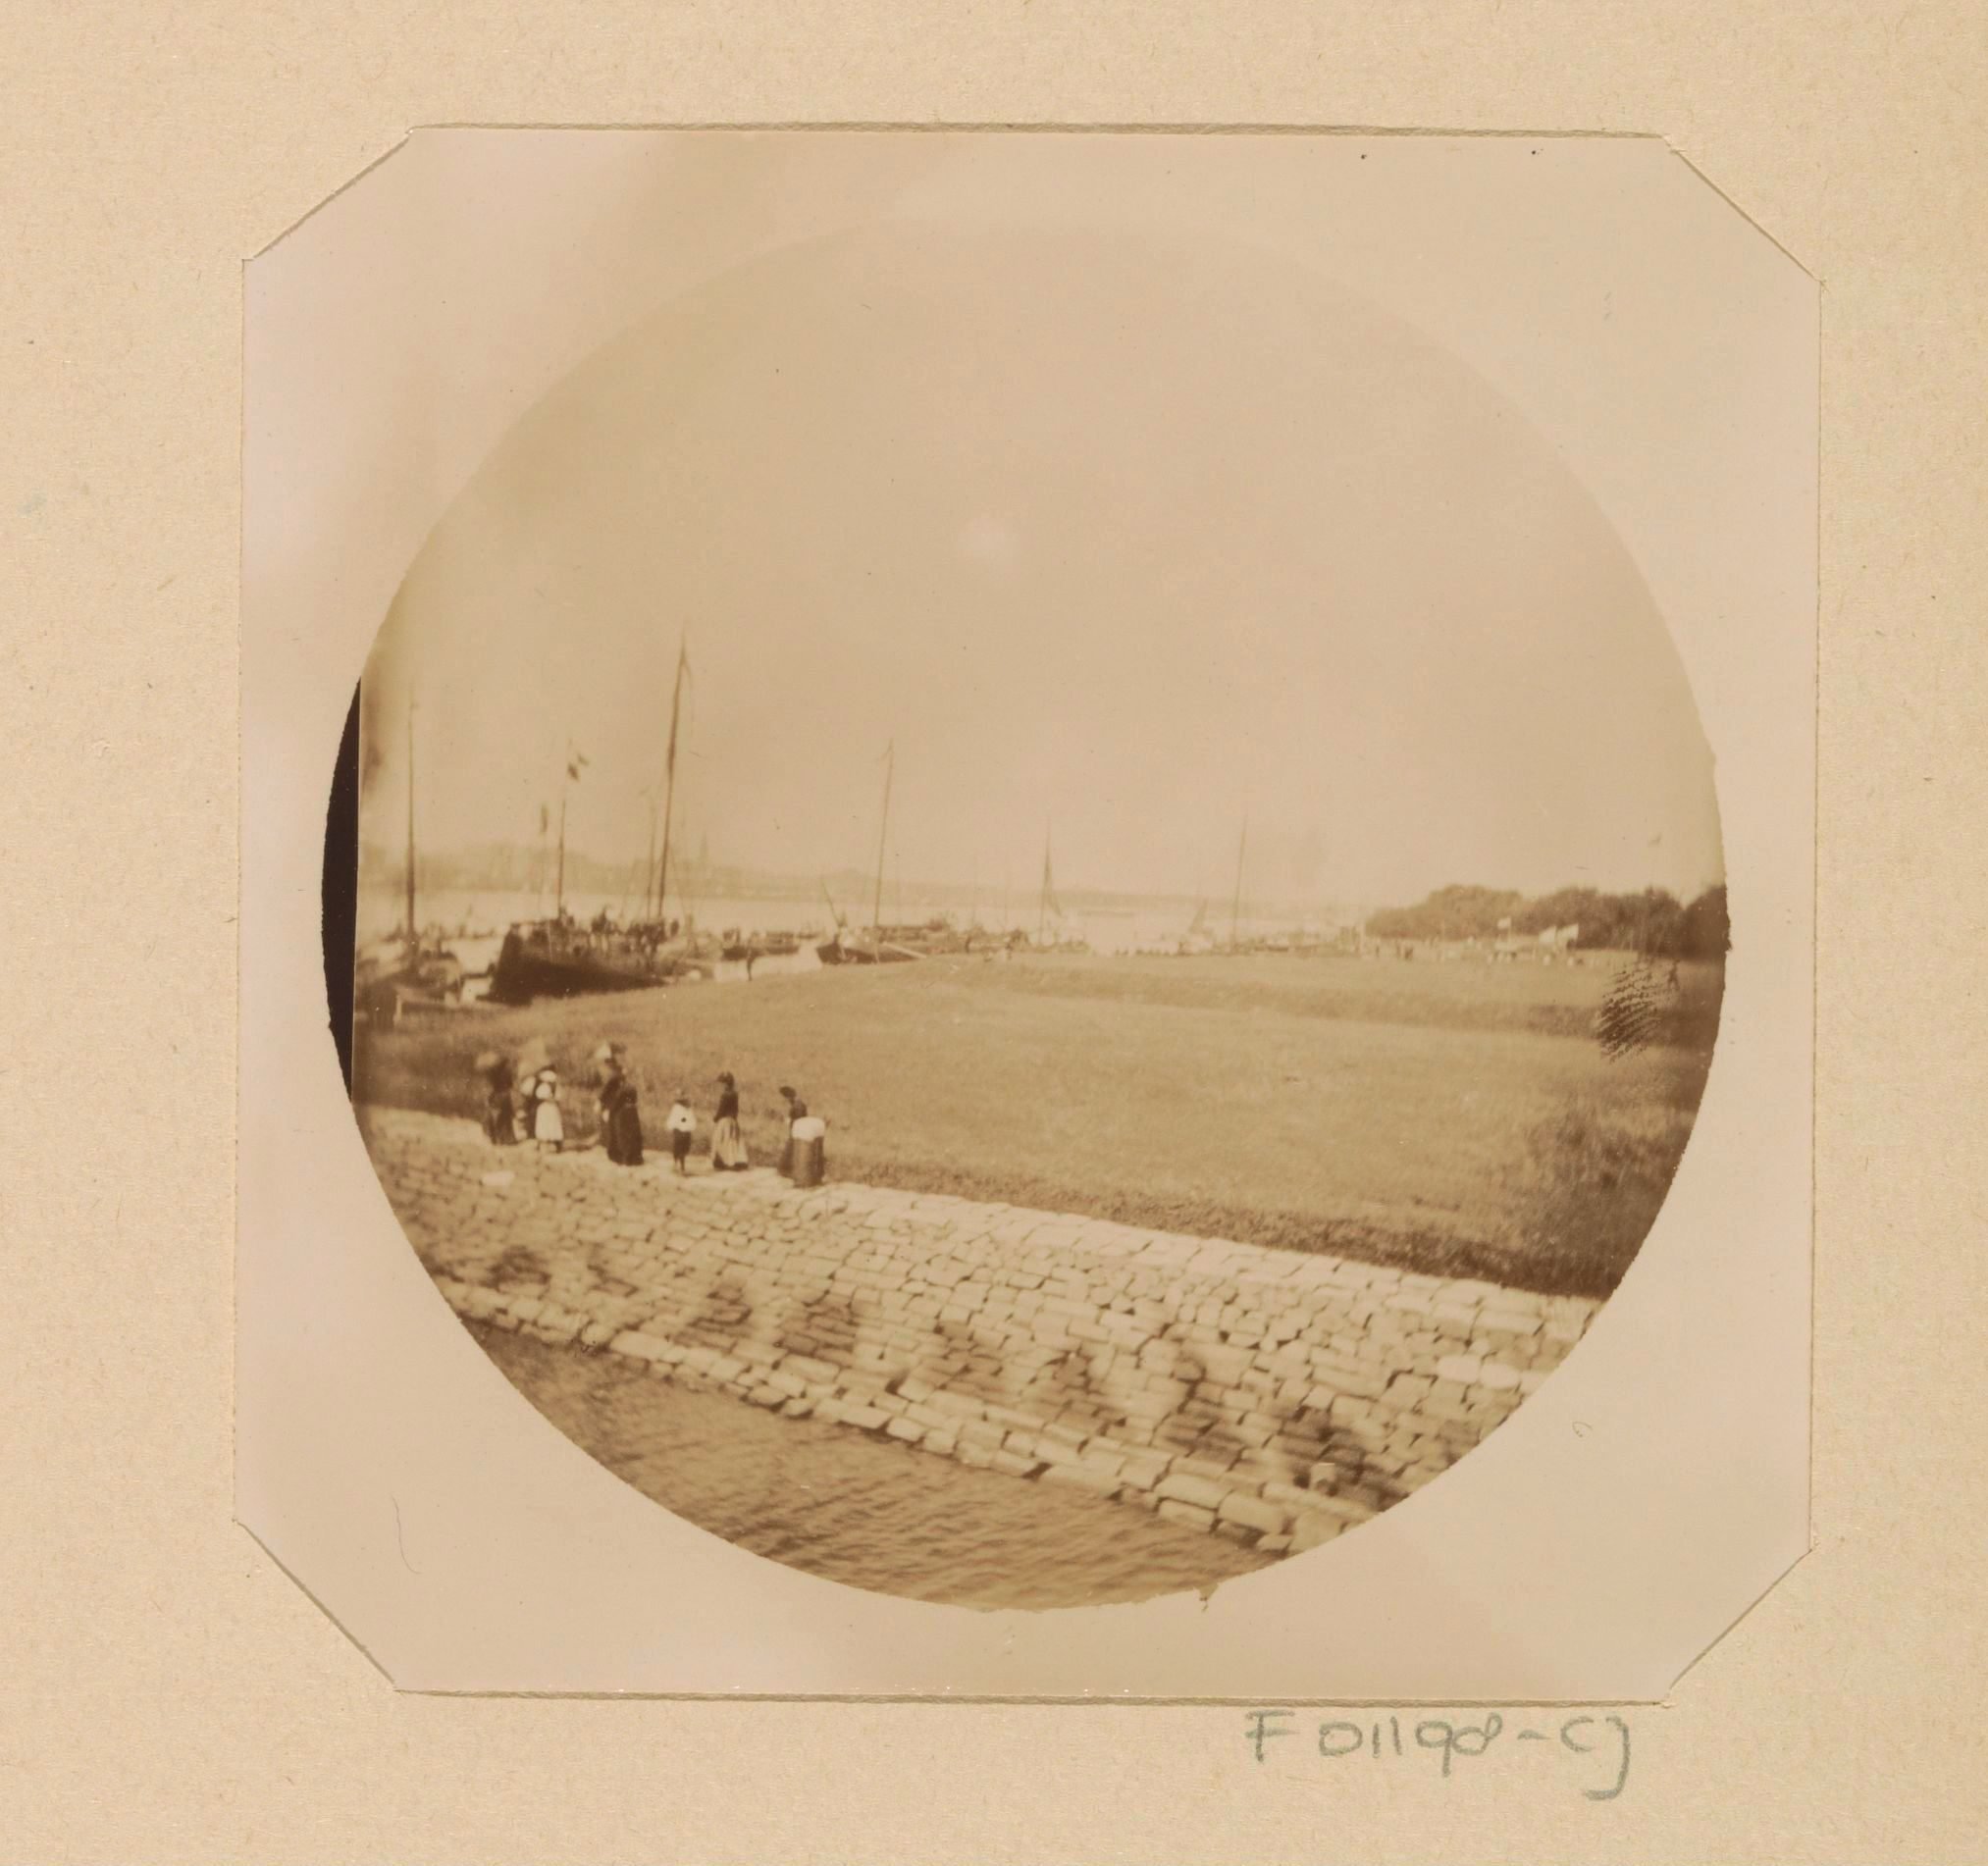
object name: photograph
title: Versierde schepen langs het IJ tijdens de Keizersfeesten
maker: johanna margaretha piek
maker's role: fotograaf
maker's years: 1870-1947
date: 1891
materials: paper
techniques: gelatin silver print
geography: amsterdam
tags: harbour, imperial celebrations 1891